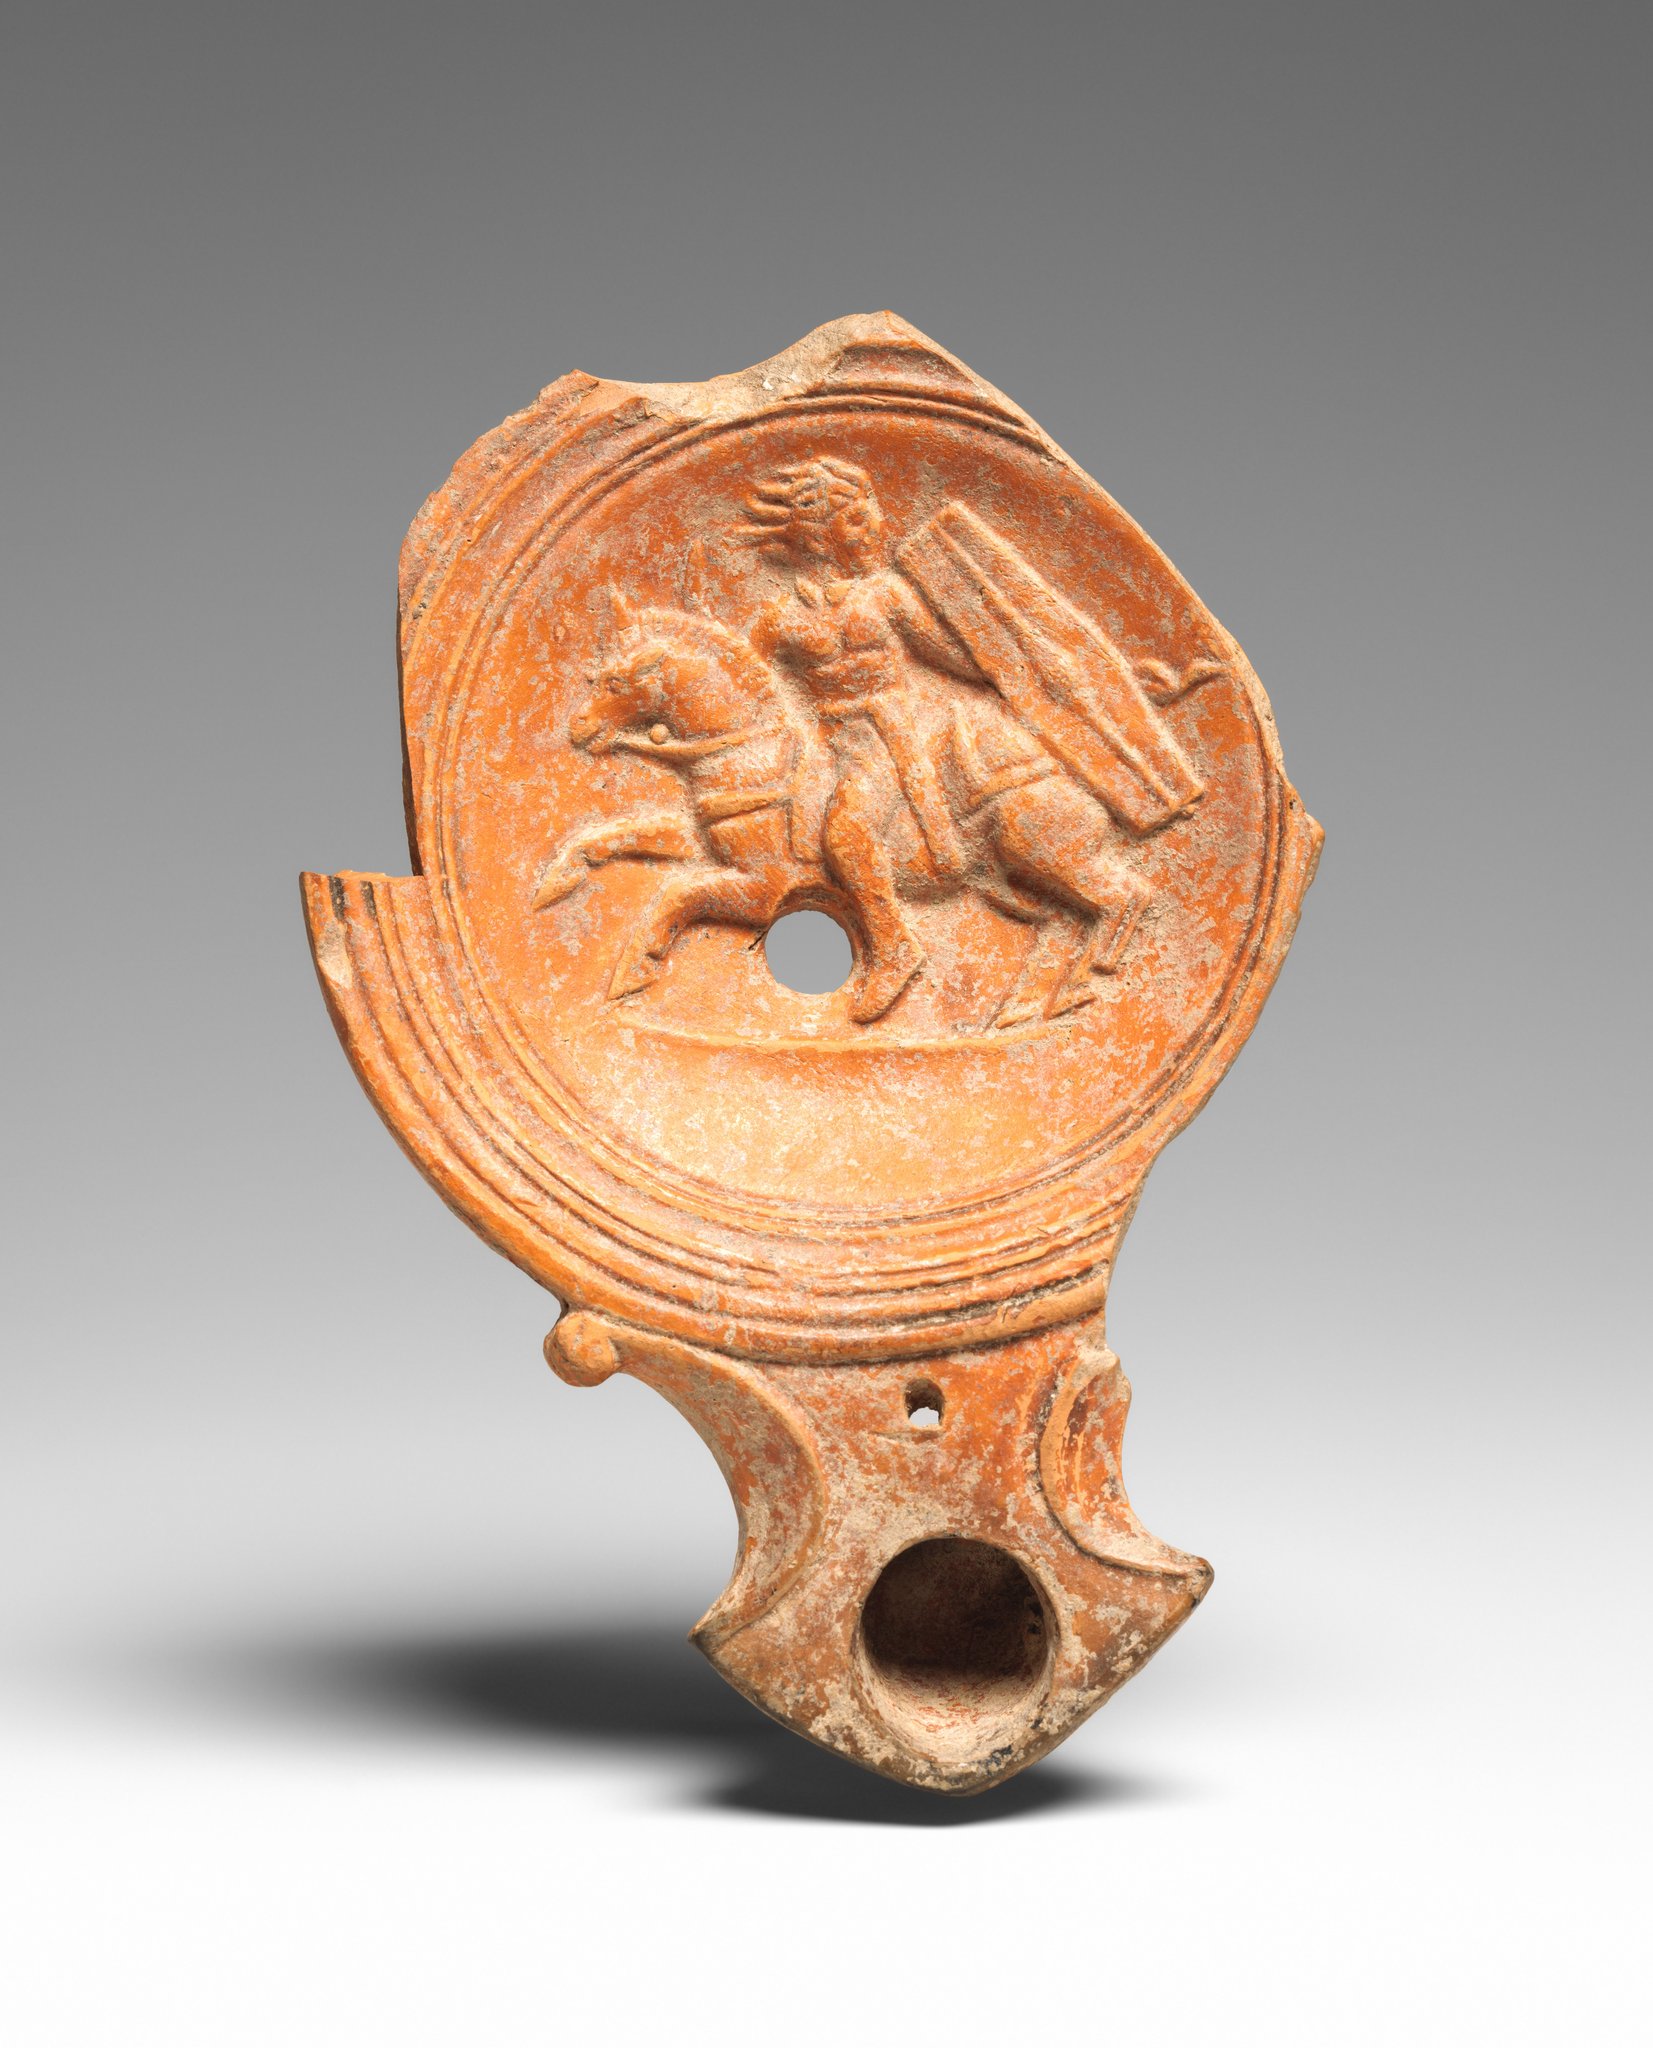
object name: lamp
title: Terracotta oil lamp fragment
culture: roman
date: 1-50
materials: terracotta